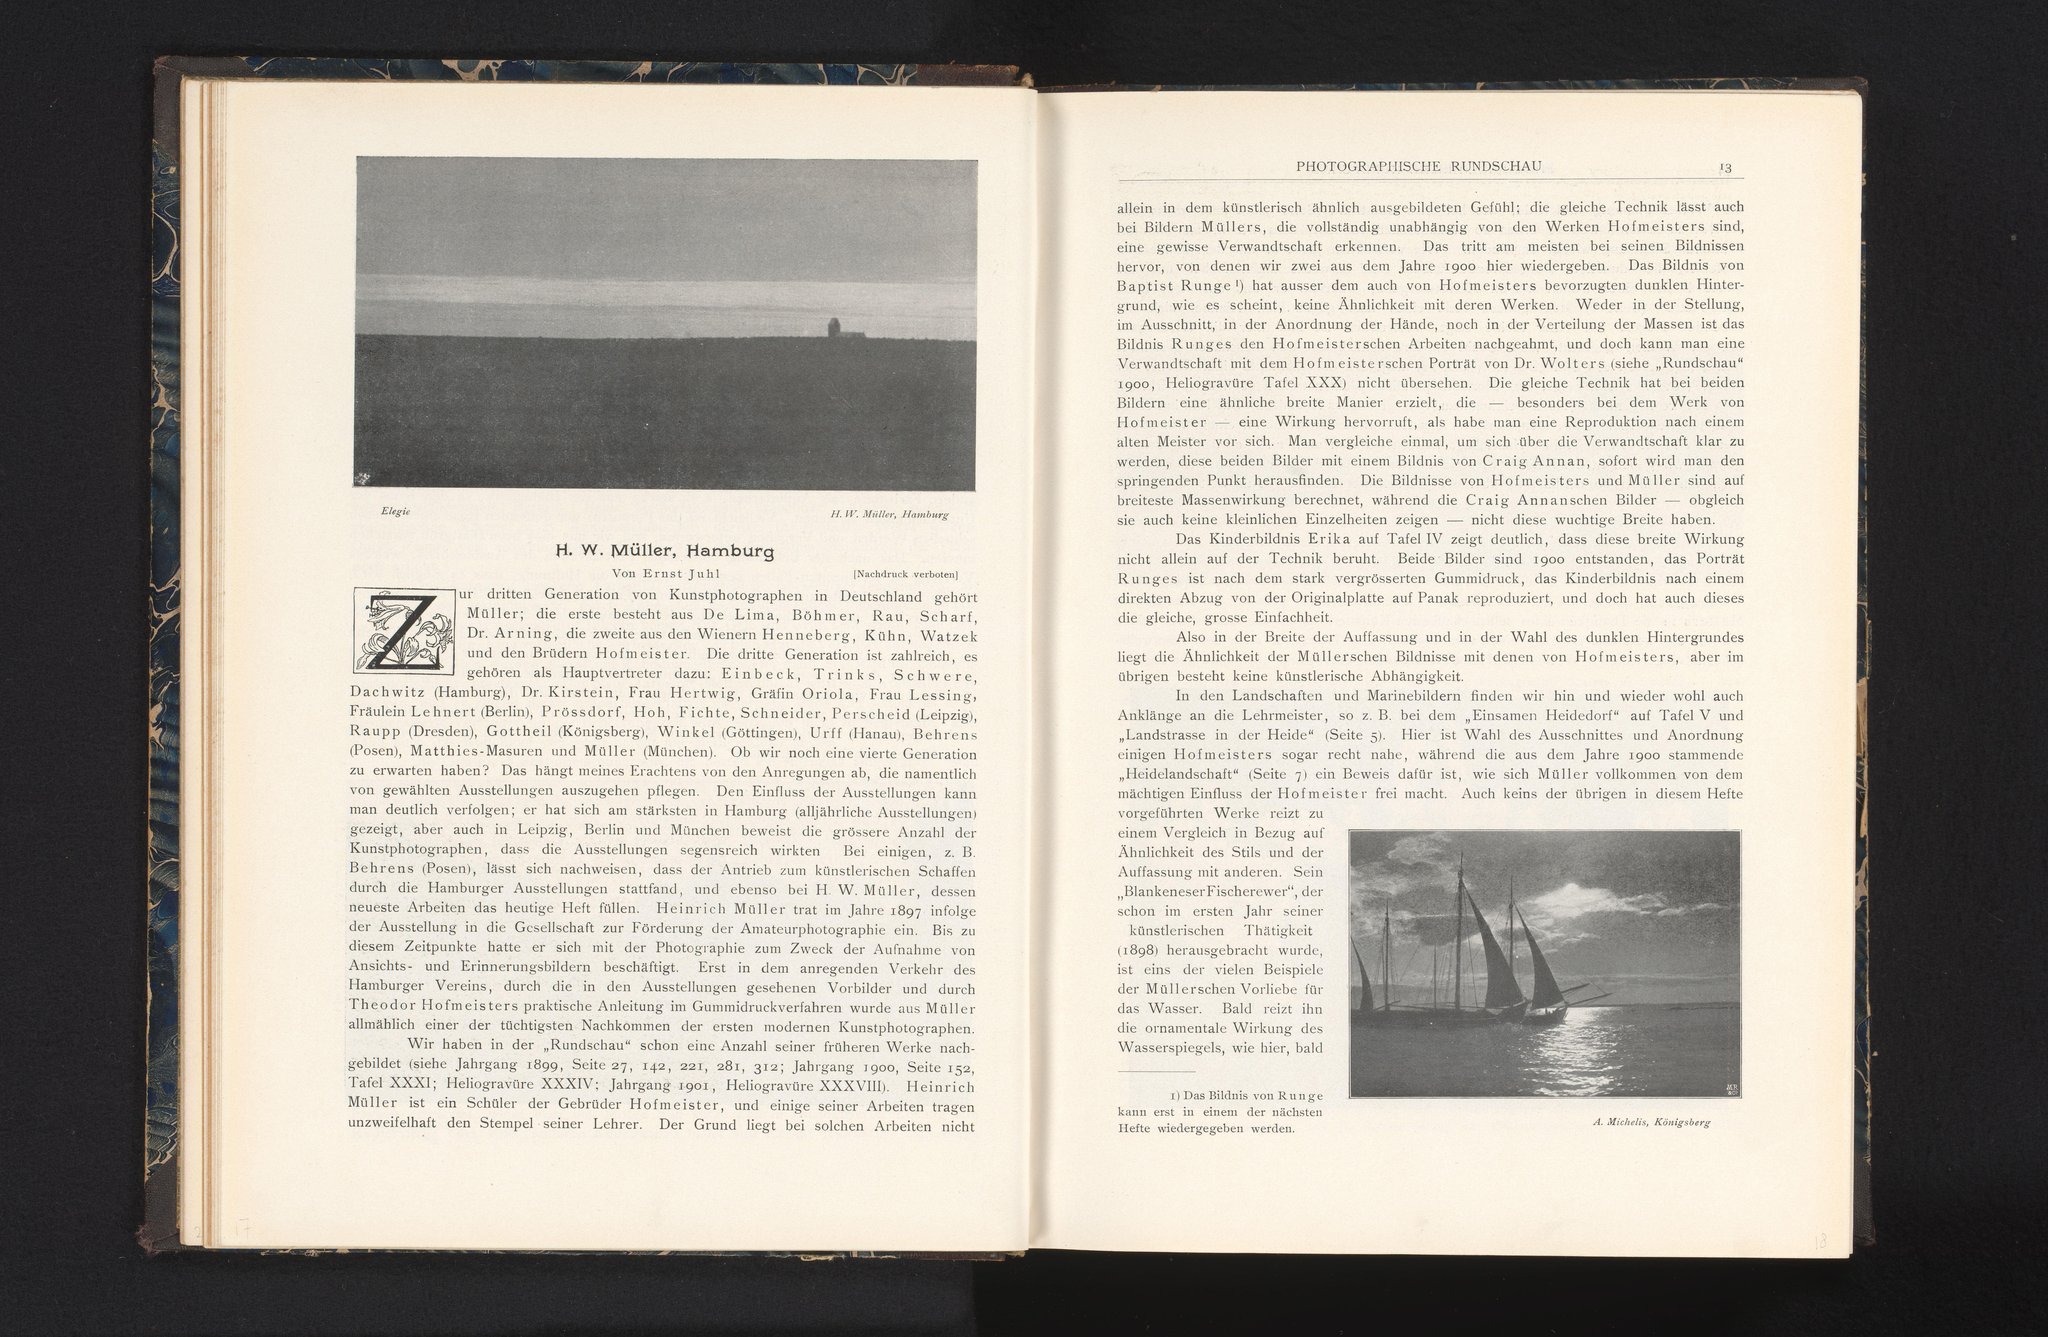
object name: page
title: Gezicht op zeilboten op het water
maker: a. michelis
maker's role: fotograaf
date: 1897-1902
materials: paper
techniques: autotype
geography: berlin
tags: sailing-ship, sailing-boat, landscapes with waters, waterscapes, seascapes (in the temperate zone)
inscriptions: monogram: ‘MR/ &Co’